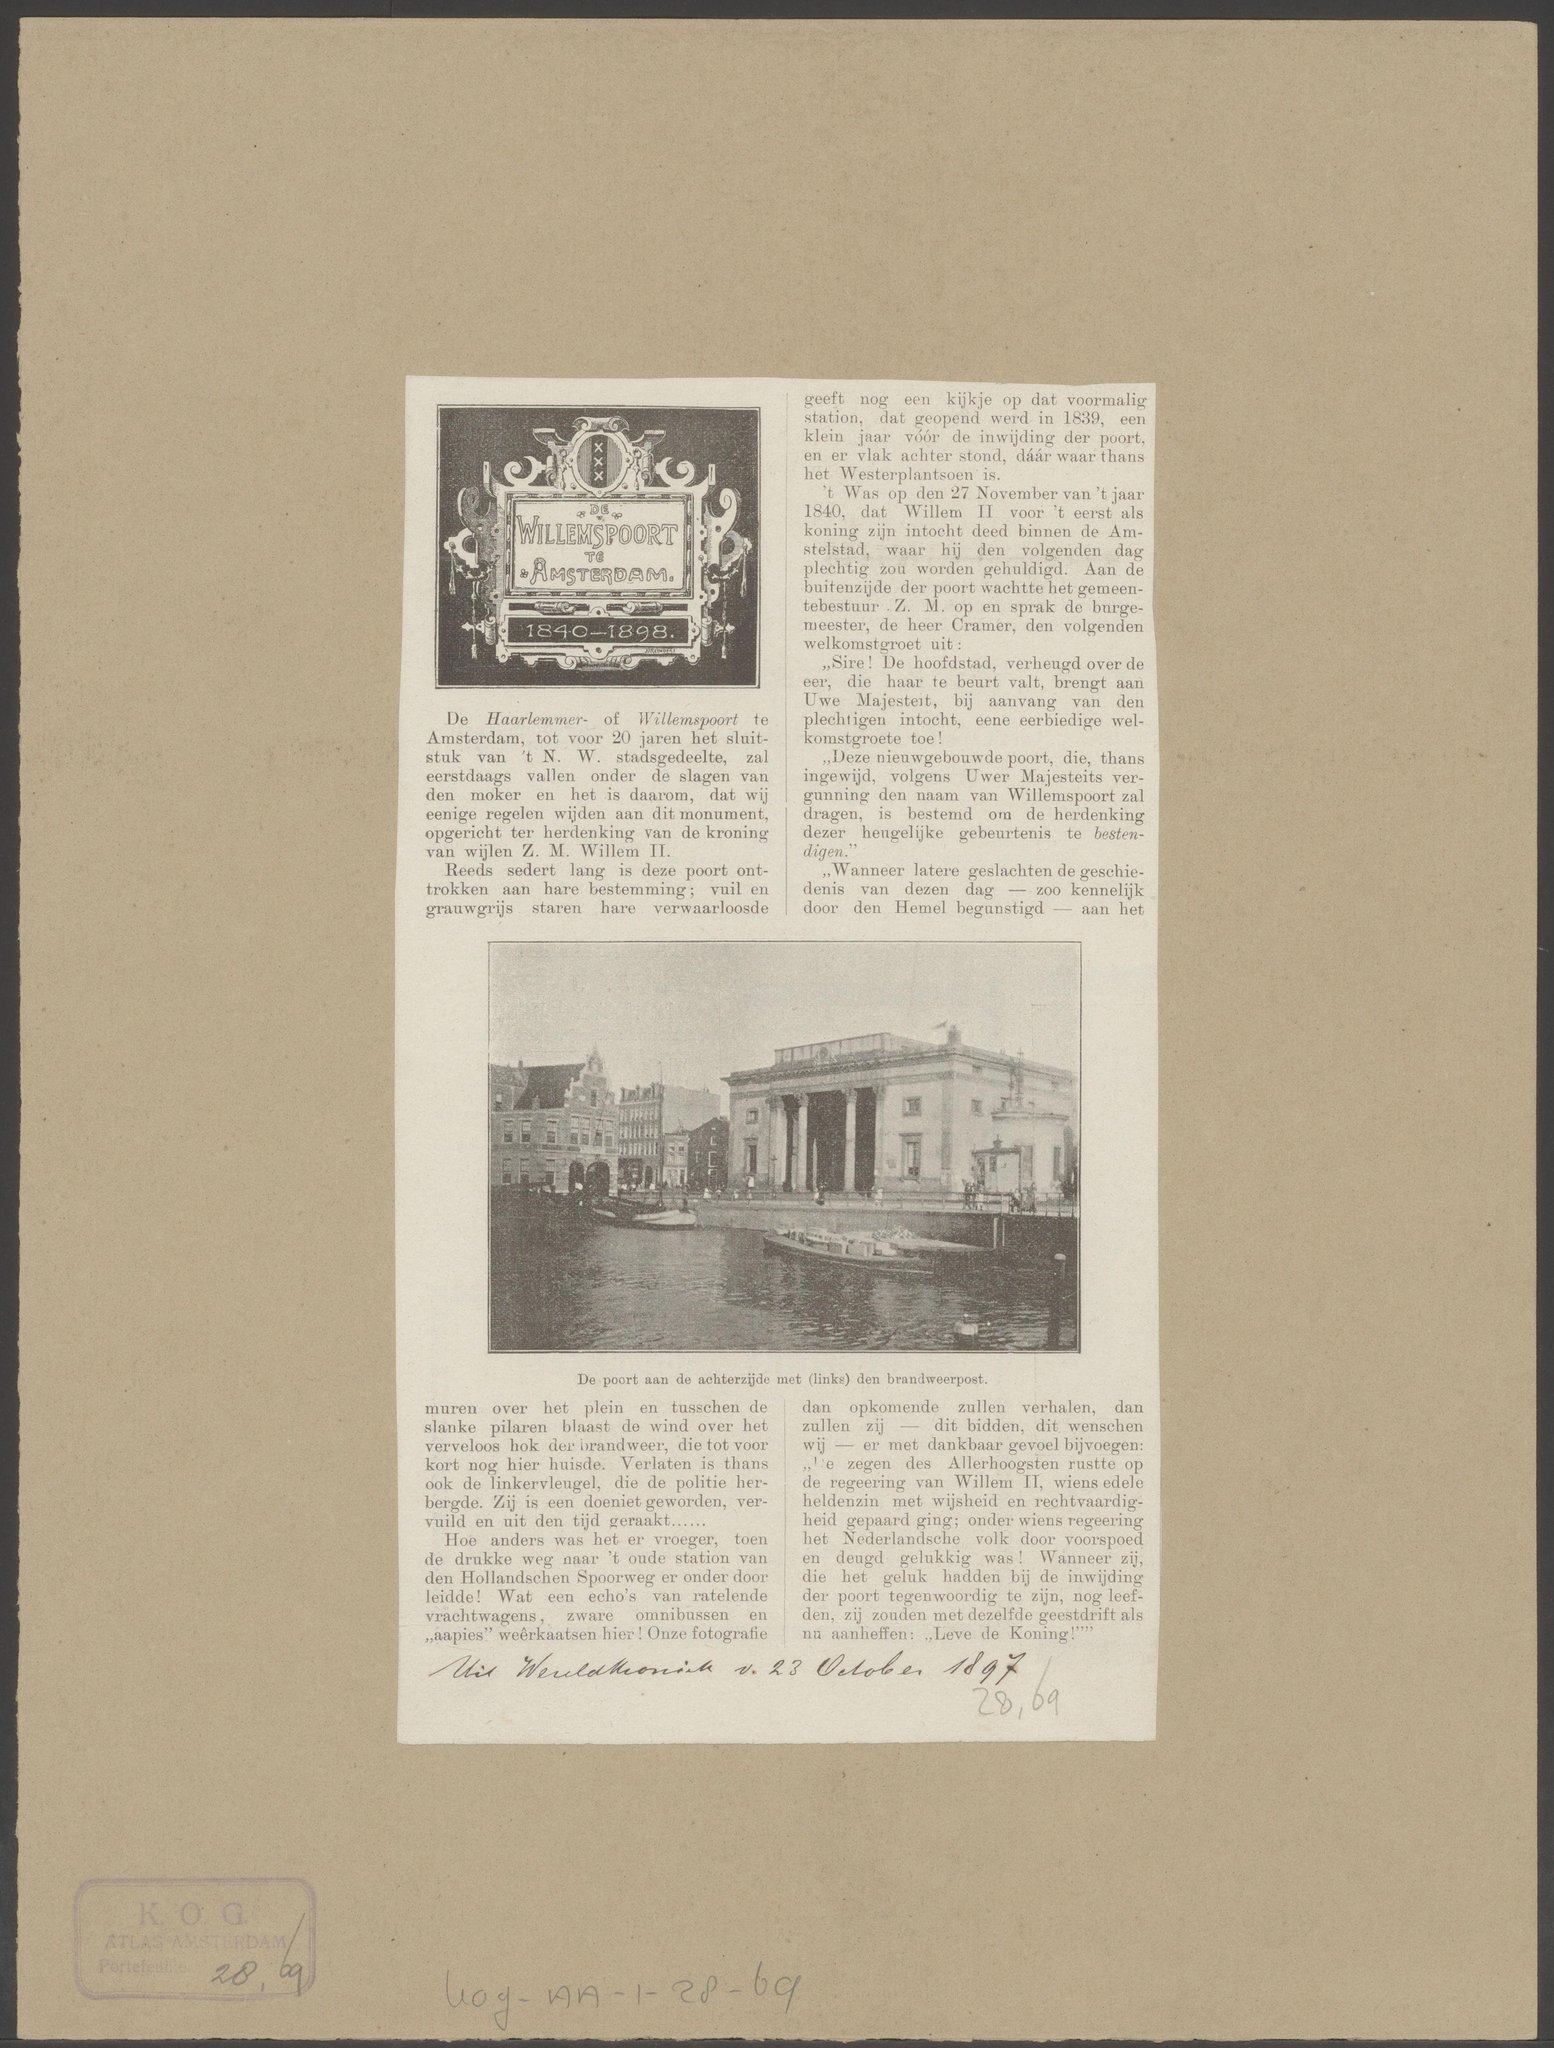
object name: photomechanical print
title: Achterzijde van de Willemspoort te Amsterdam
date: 1897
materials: paper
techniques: letterpress printing, line block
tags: city-gate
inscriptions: collector's mark: Lugt 1641b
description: Achterzijde van de Willemspoort te Amsterdam. Onderwerpsrubriek binnen de Atlas Amsterdam: Poorten, verzamelbladen, F. Willemspoort.